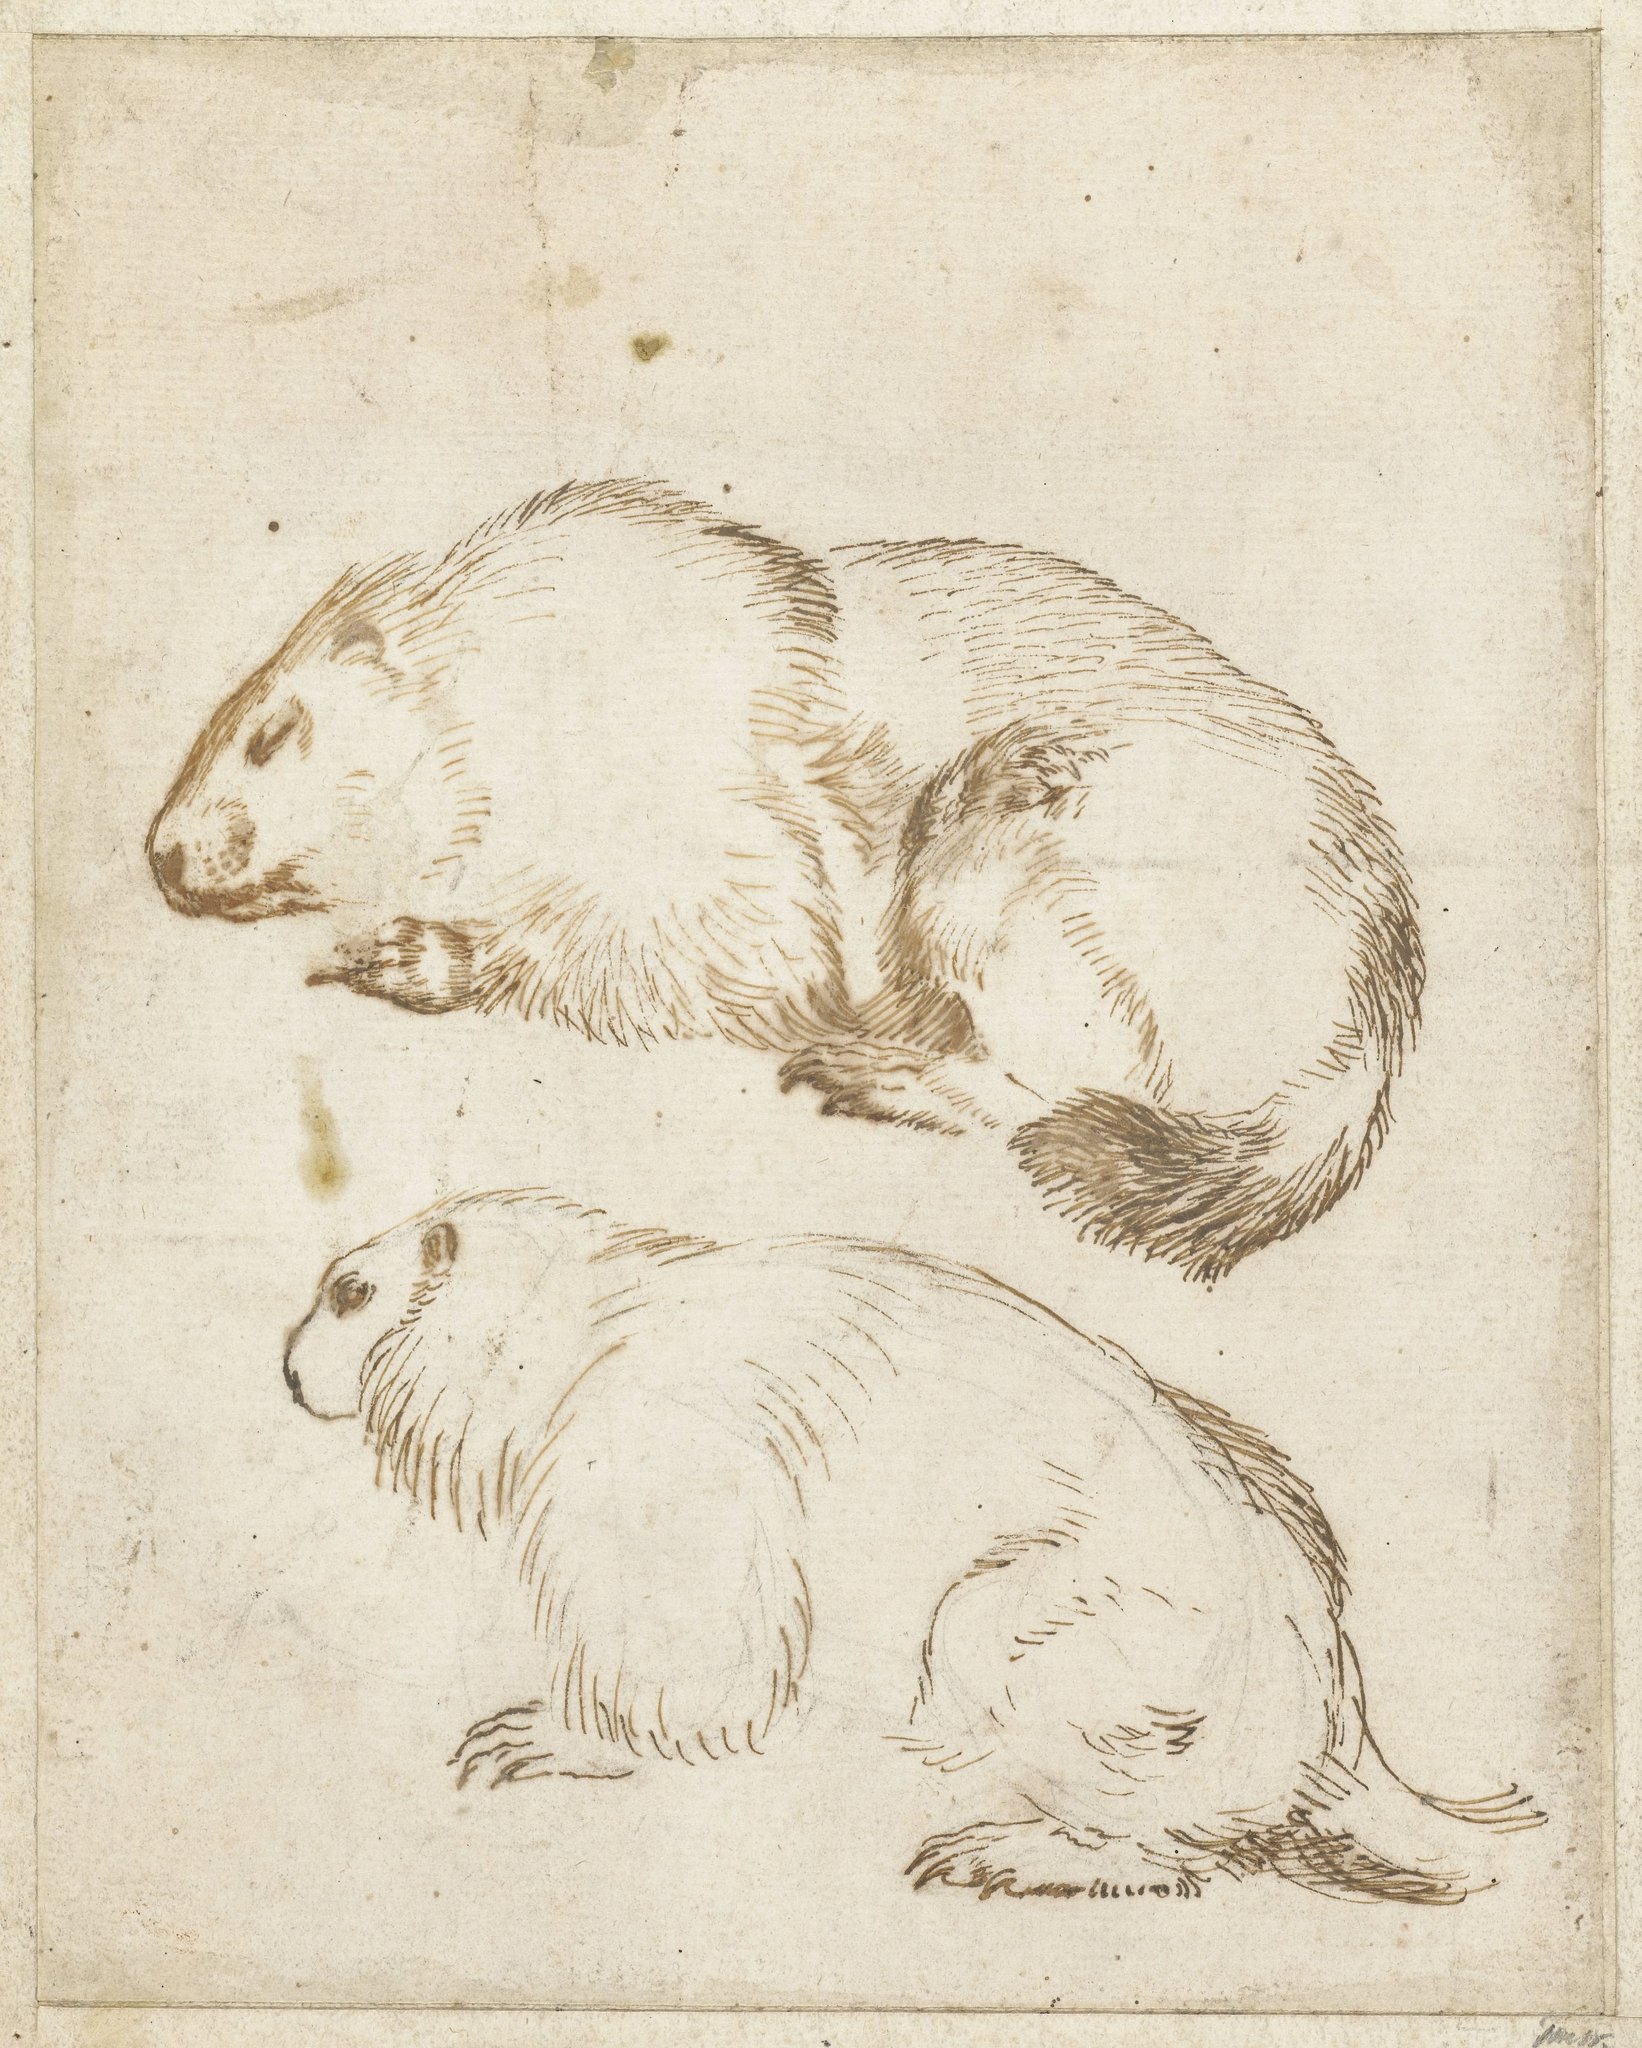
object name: drawing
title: Two Studies of a Marmot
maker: sinibaldo scorza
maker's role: draughtsman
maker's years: 1589-1631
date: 1620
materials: ink, paper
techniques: pen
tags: rodents: guinea pig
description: The Italian artist Sinibaldo Scorza, to whom this sheet has recently been attributed, depicted not only horses, lions, and exotic birds in his paintings, but also had an eye for small, less spectacular animals. This marmot was probably drawn from life. The artist first lightly sketched the contours in black chalk, and then worked up the little creature’s bristly fur in pen and brown ink.